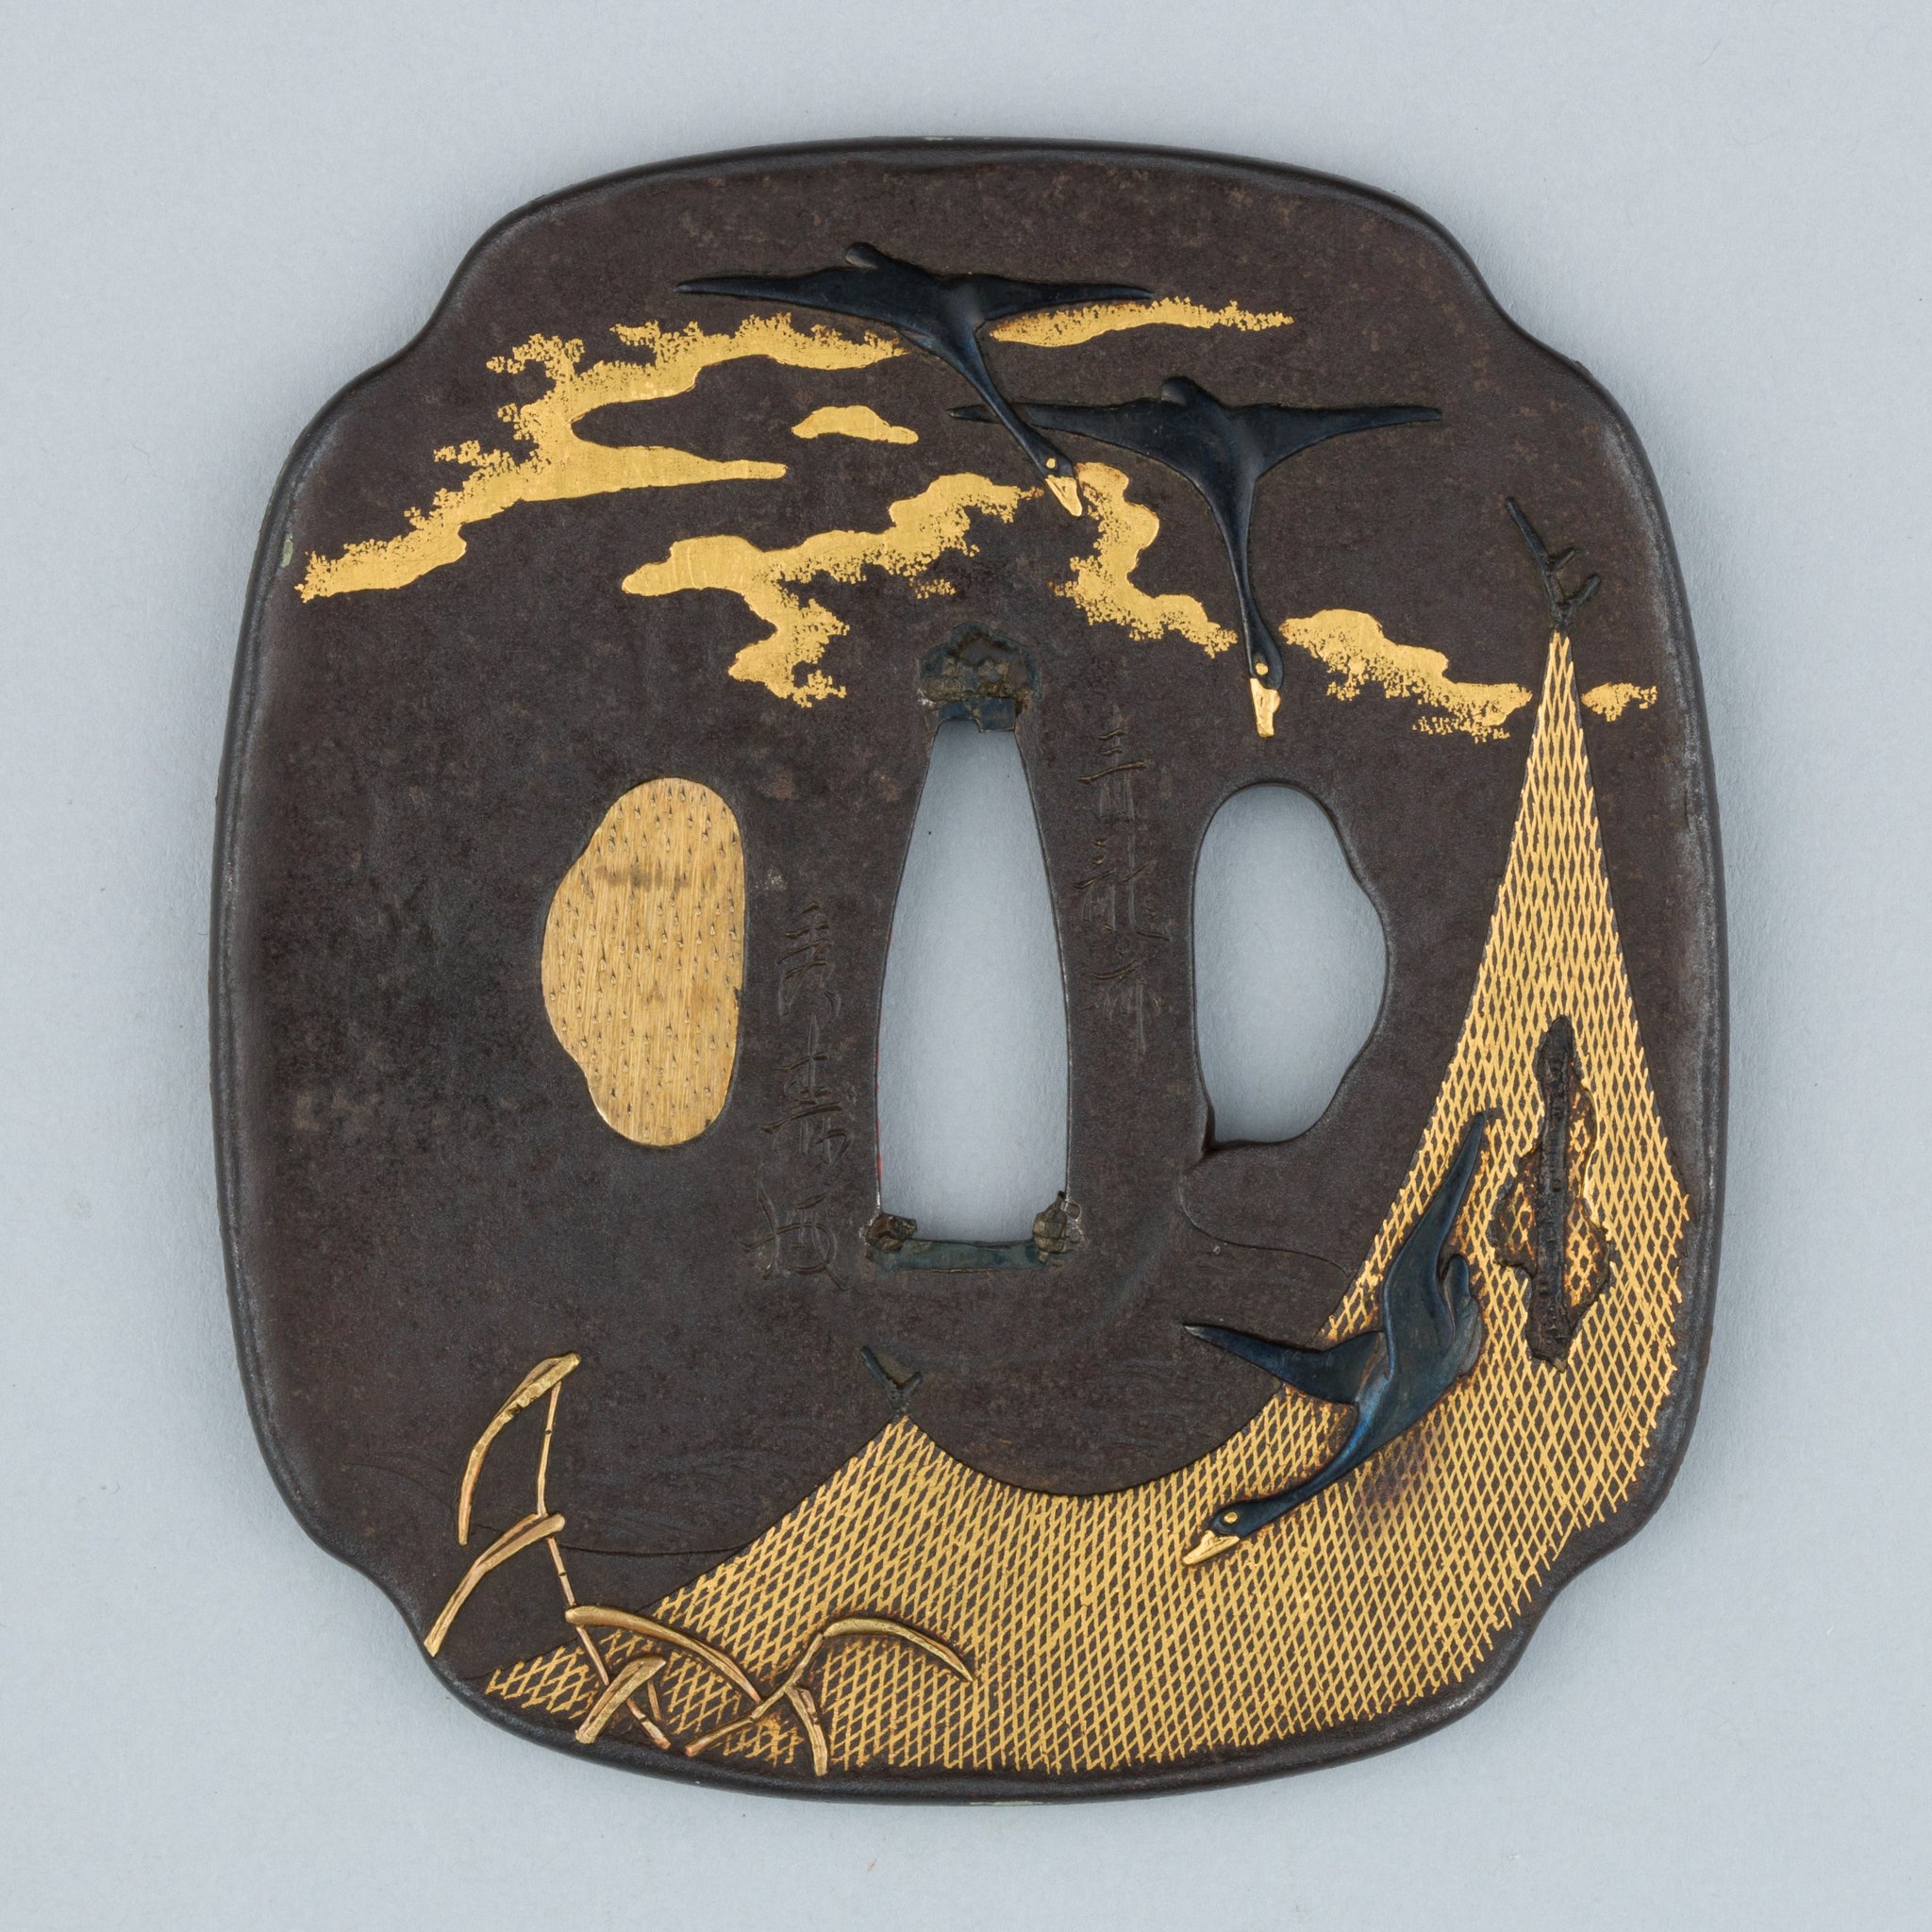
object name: sword guard tsuba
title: Sword Guard (Tsuba)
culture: japanese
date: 1860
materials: copper, gold alloy, gold, iron, silver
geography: japan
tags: birds